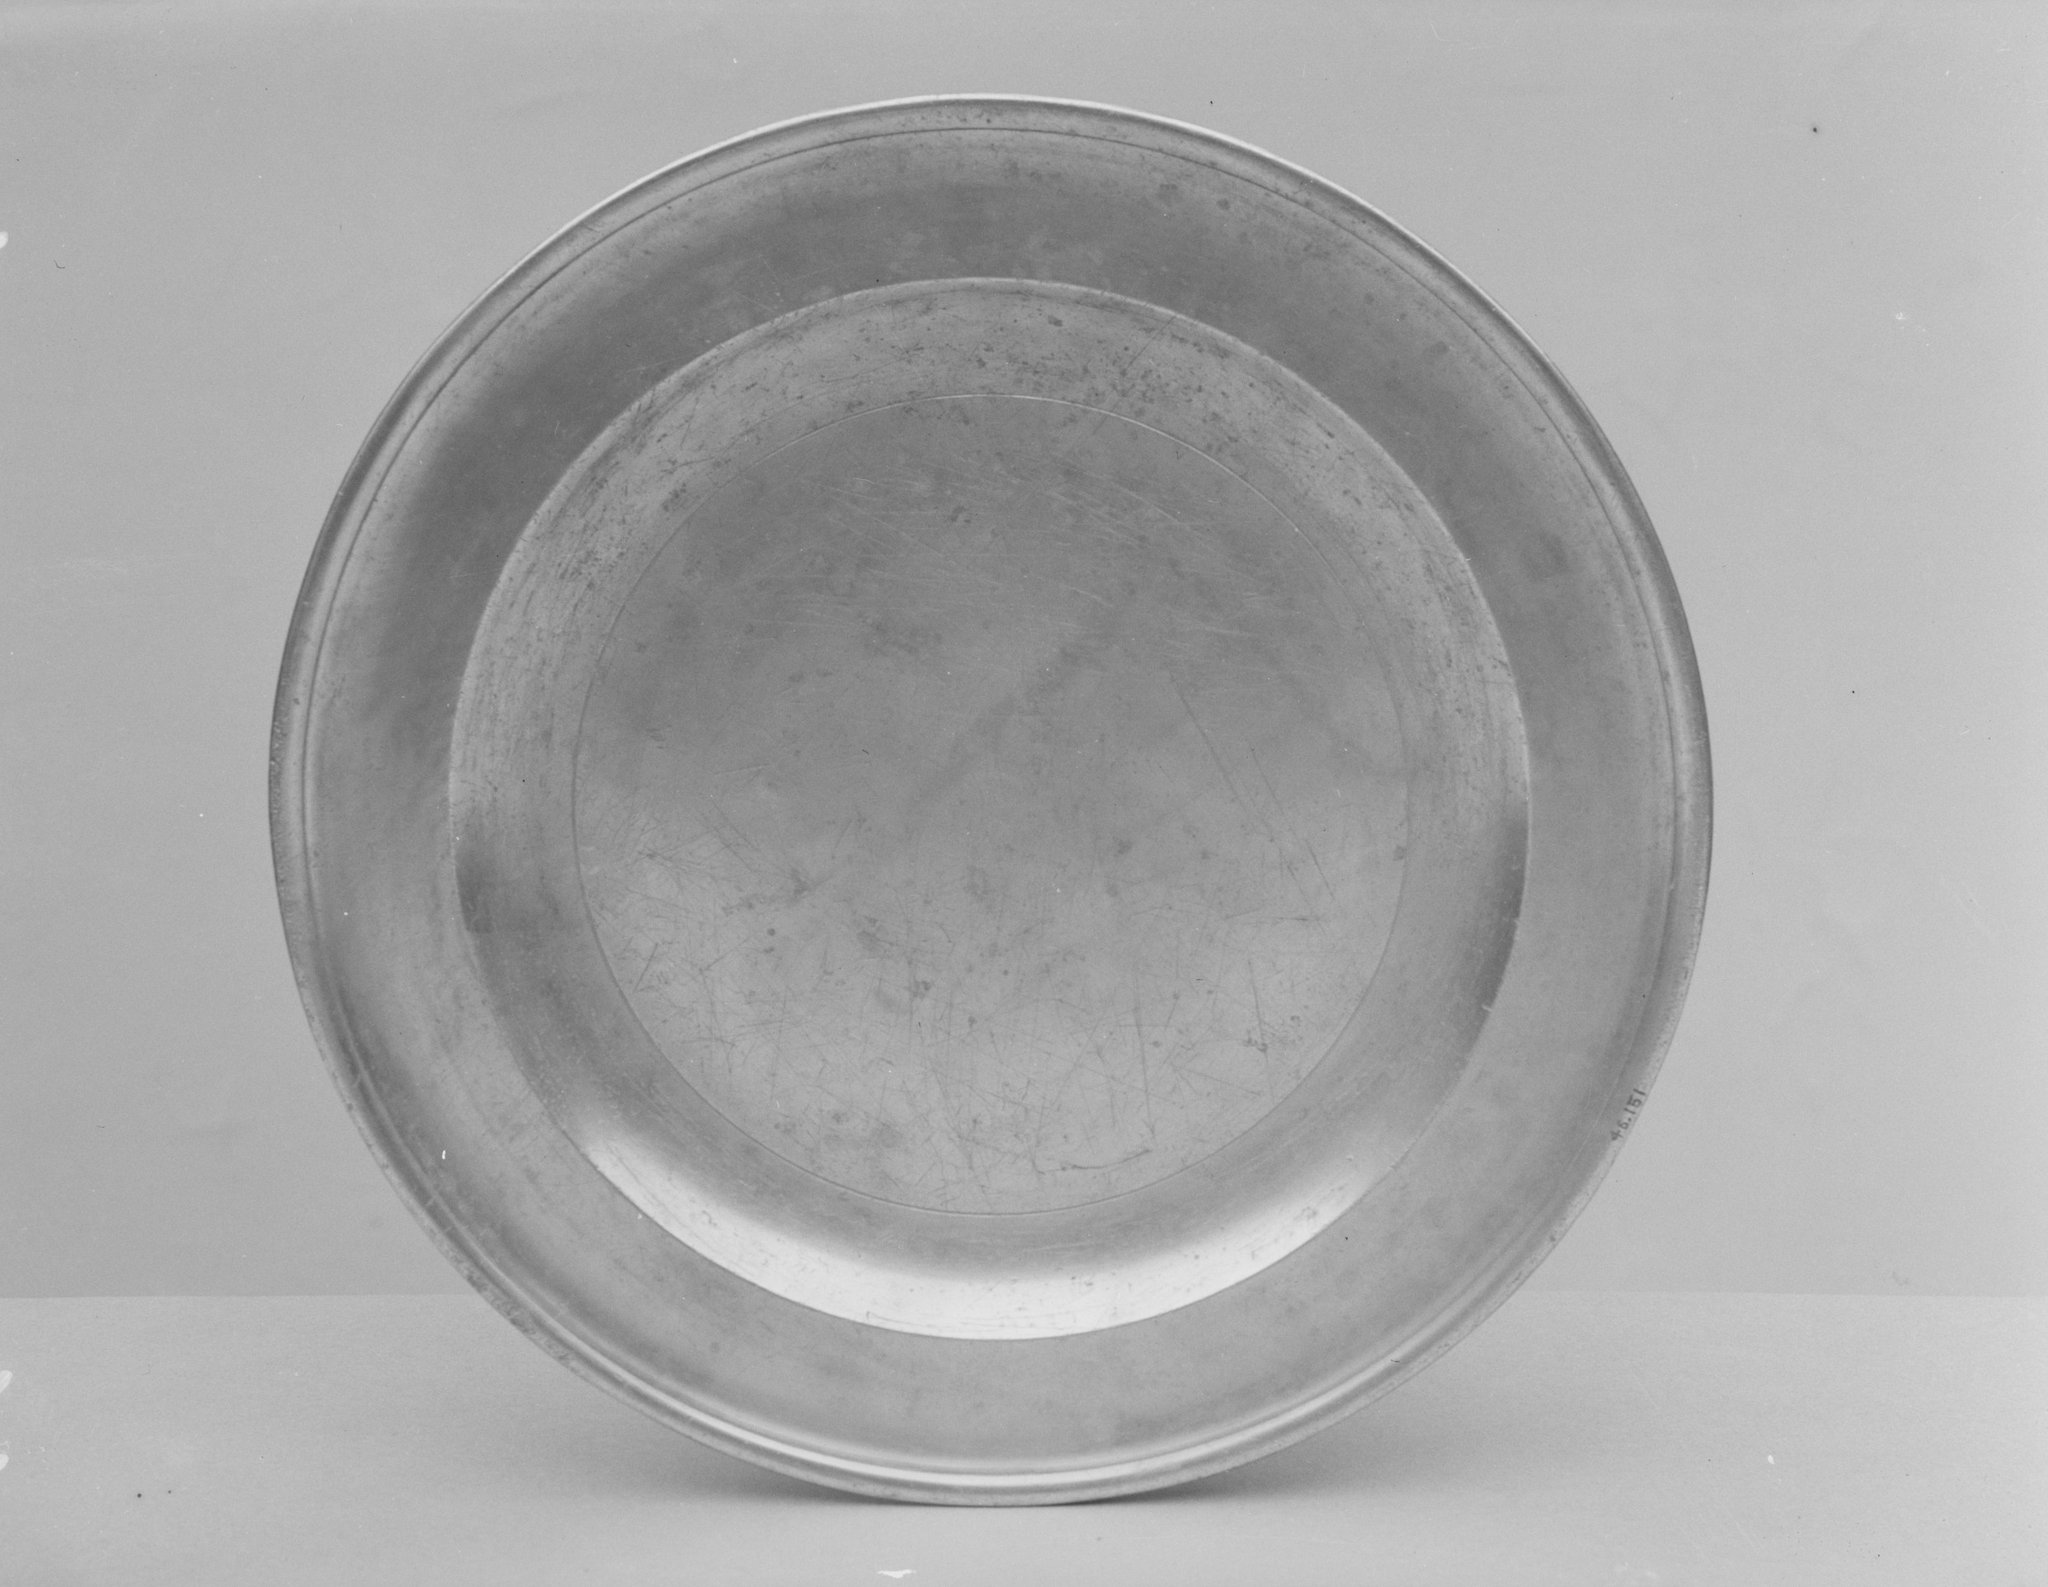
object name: dish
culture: american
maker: thomas danforth, i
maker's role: maker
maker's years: 1703-1786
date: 1762-1773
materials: pewter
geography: united states